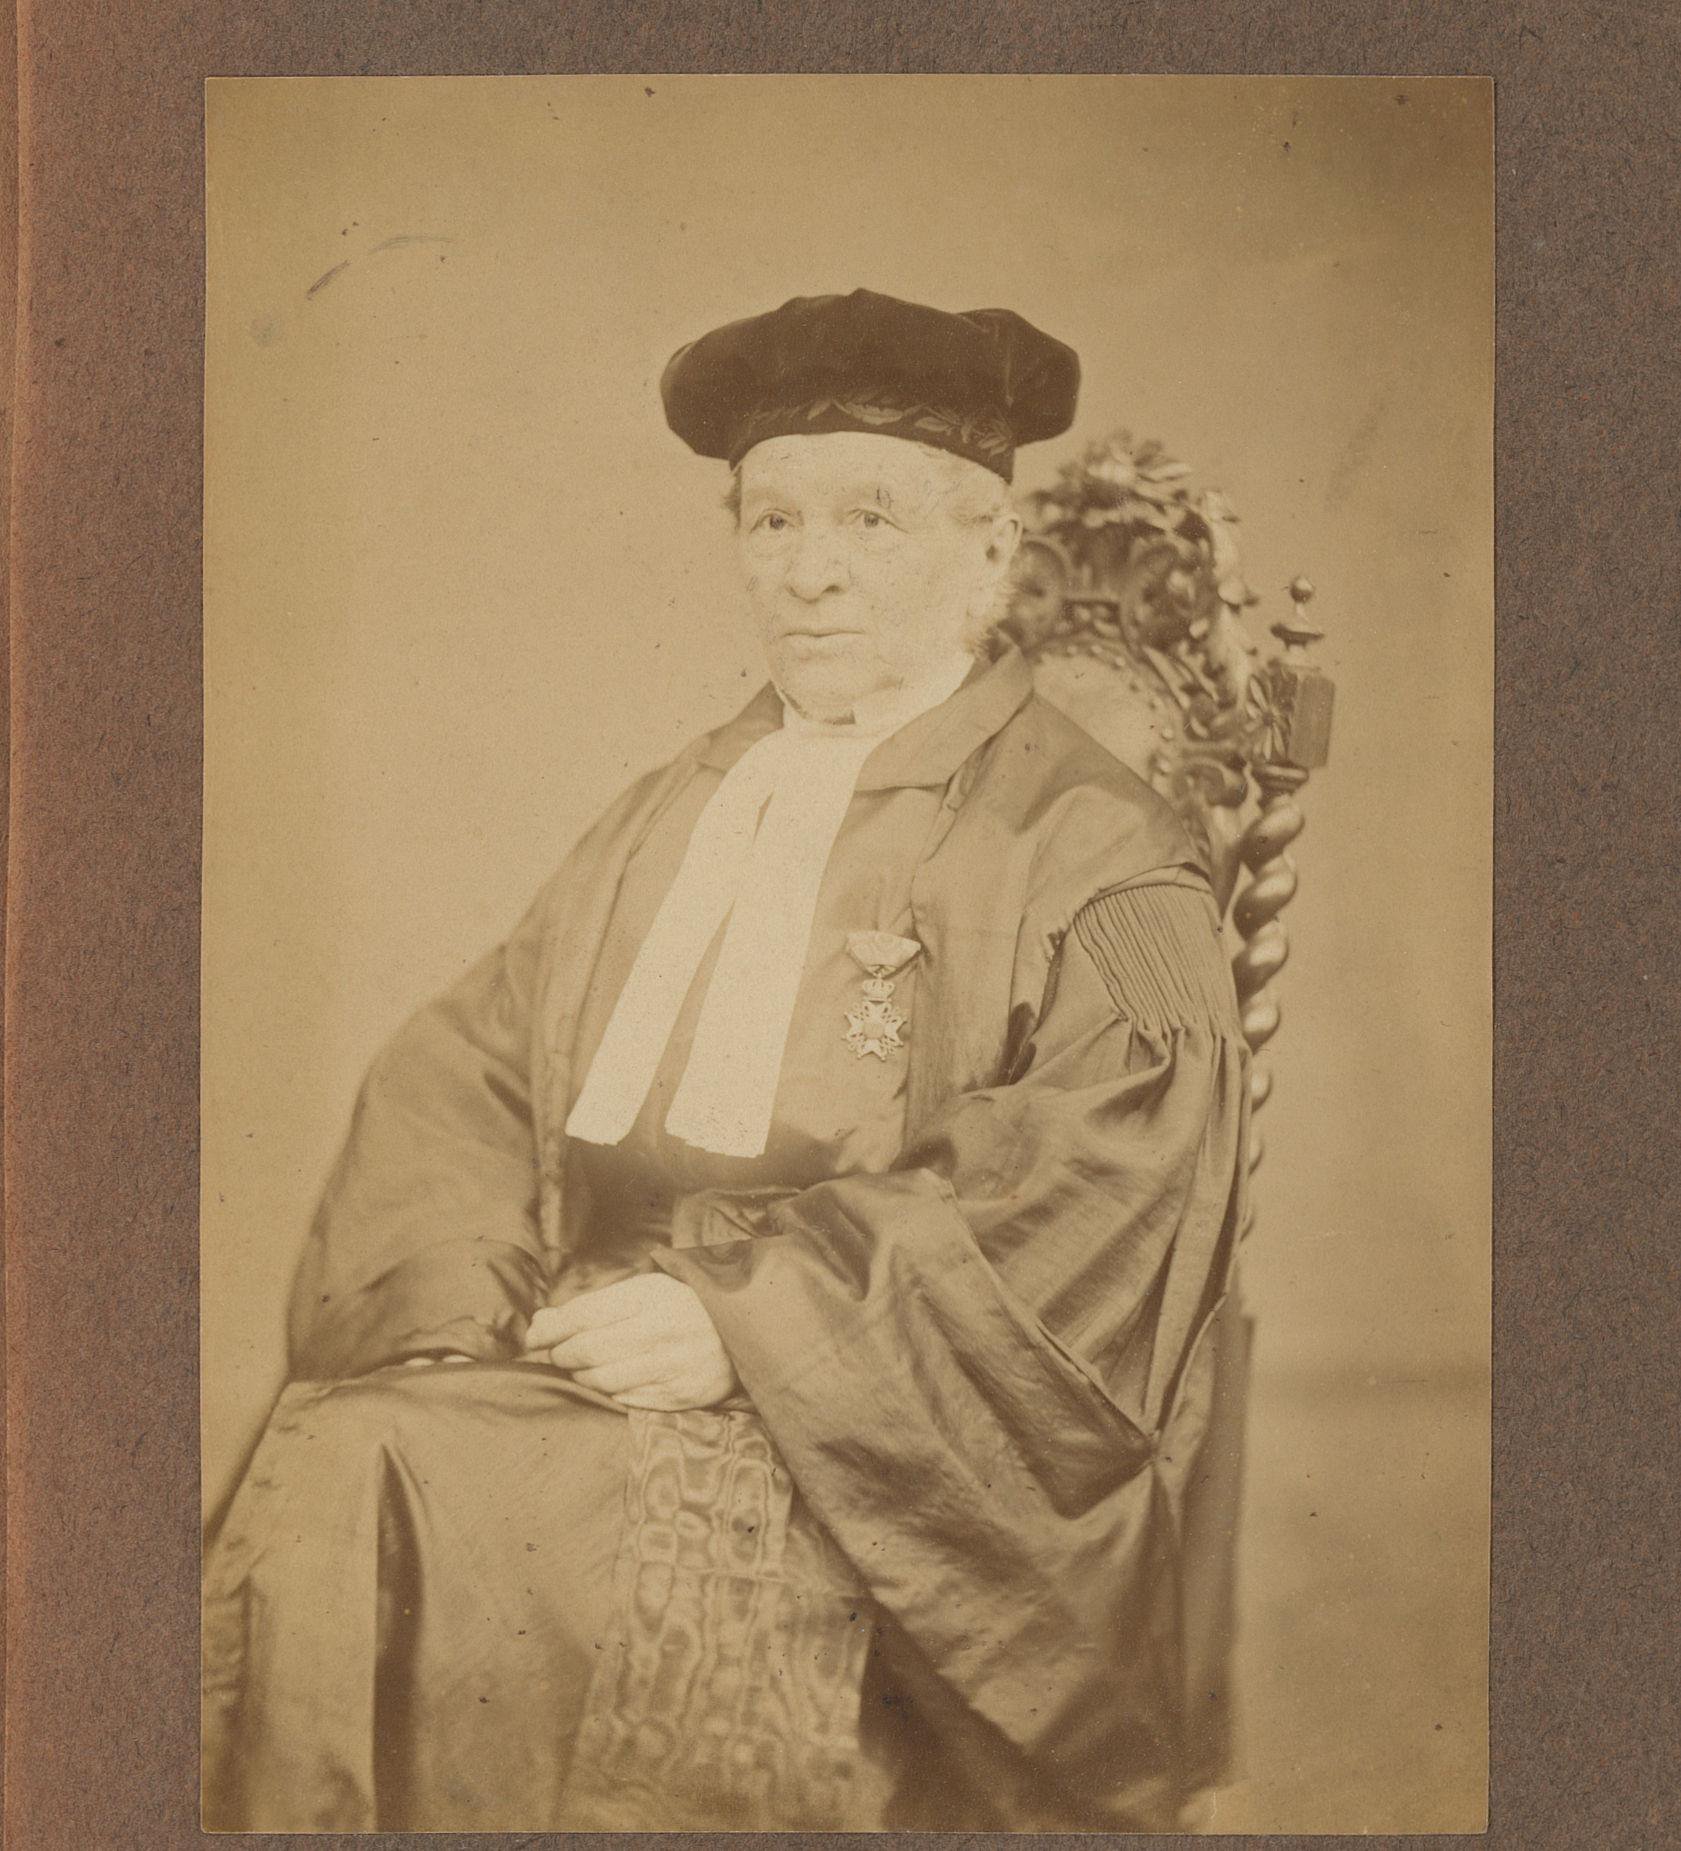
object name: photograph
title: Overgrootvader J.G. de Jong van Beek en Donk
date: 1876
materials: photographic support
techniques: photography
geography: amsterdam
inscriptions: inscription: ‘Overgrootvader J.G. de Jong / van Beek en Donk / 1876.’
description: Foto op bruin albumblad 20 van familiealbum van Alphons Diepenbrock.